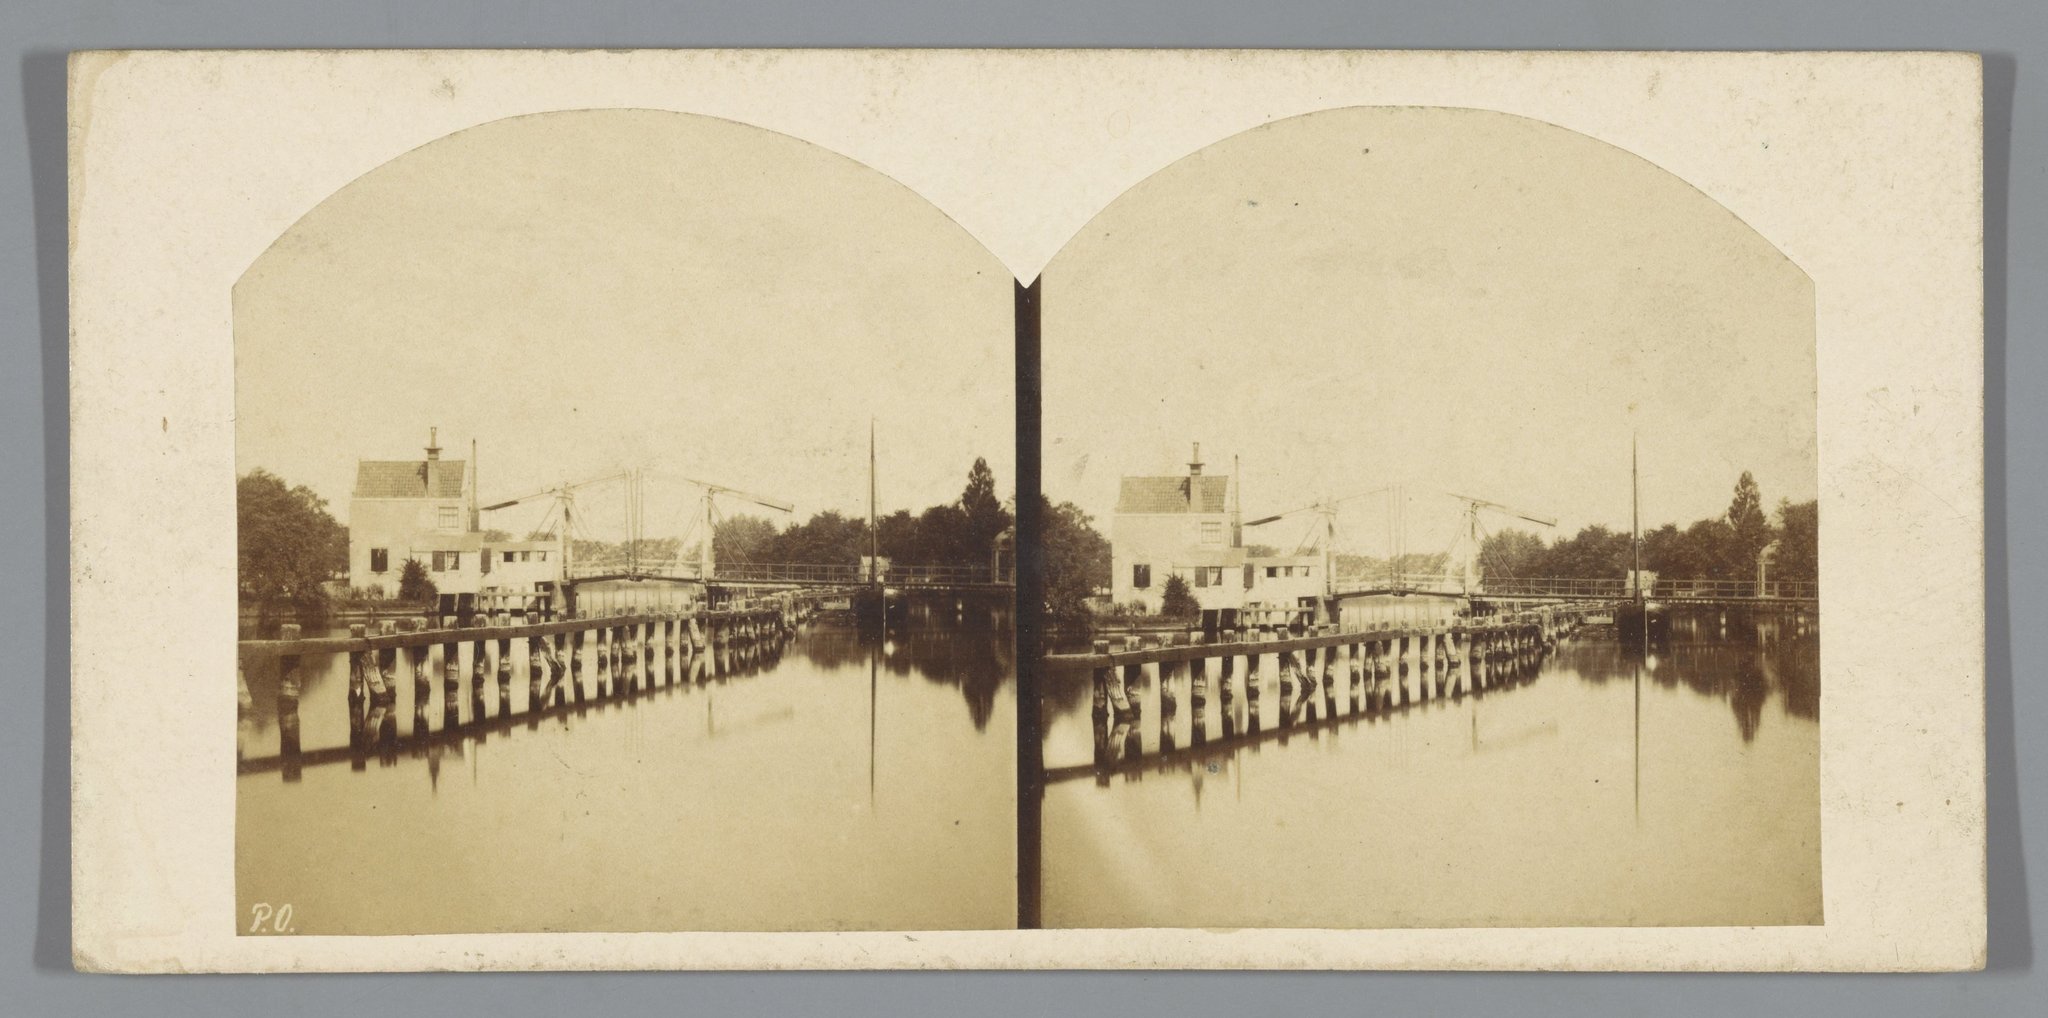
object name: stereograph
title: Ouderkerk aan de Amstel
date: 1859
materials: cardboard, paper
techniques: albumen print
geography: amsterdam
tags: village, bridge in village across river, canal, etc.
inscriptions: initials: ‘P.O.’, inscription: ‘foto Pieter Oosterhuis’, inscription: ‘Gephotographiëerd in Julij 1859./ Uitgegeven door A. Jager, Water 110, te Amsterdam.’